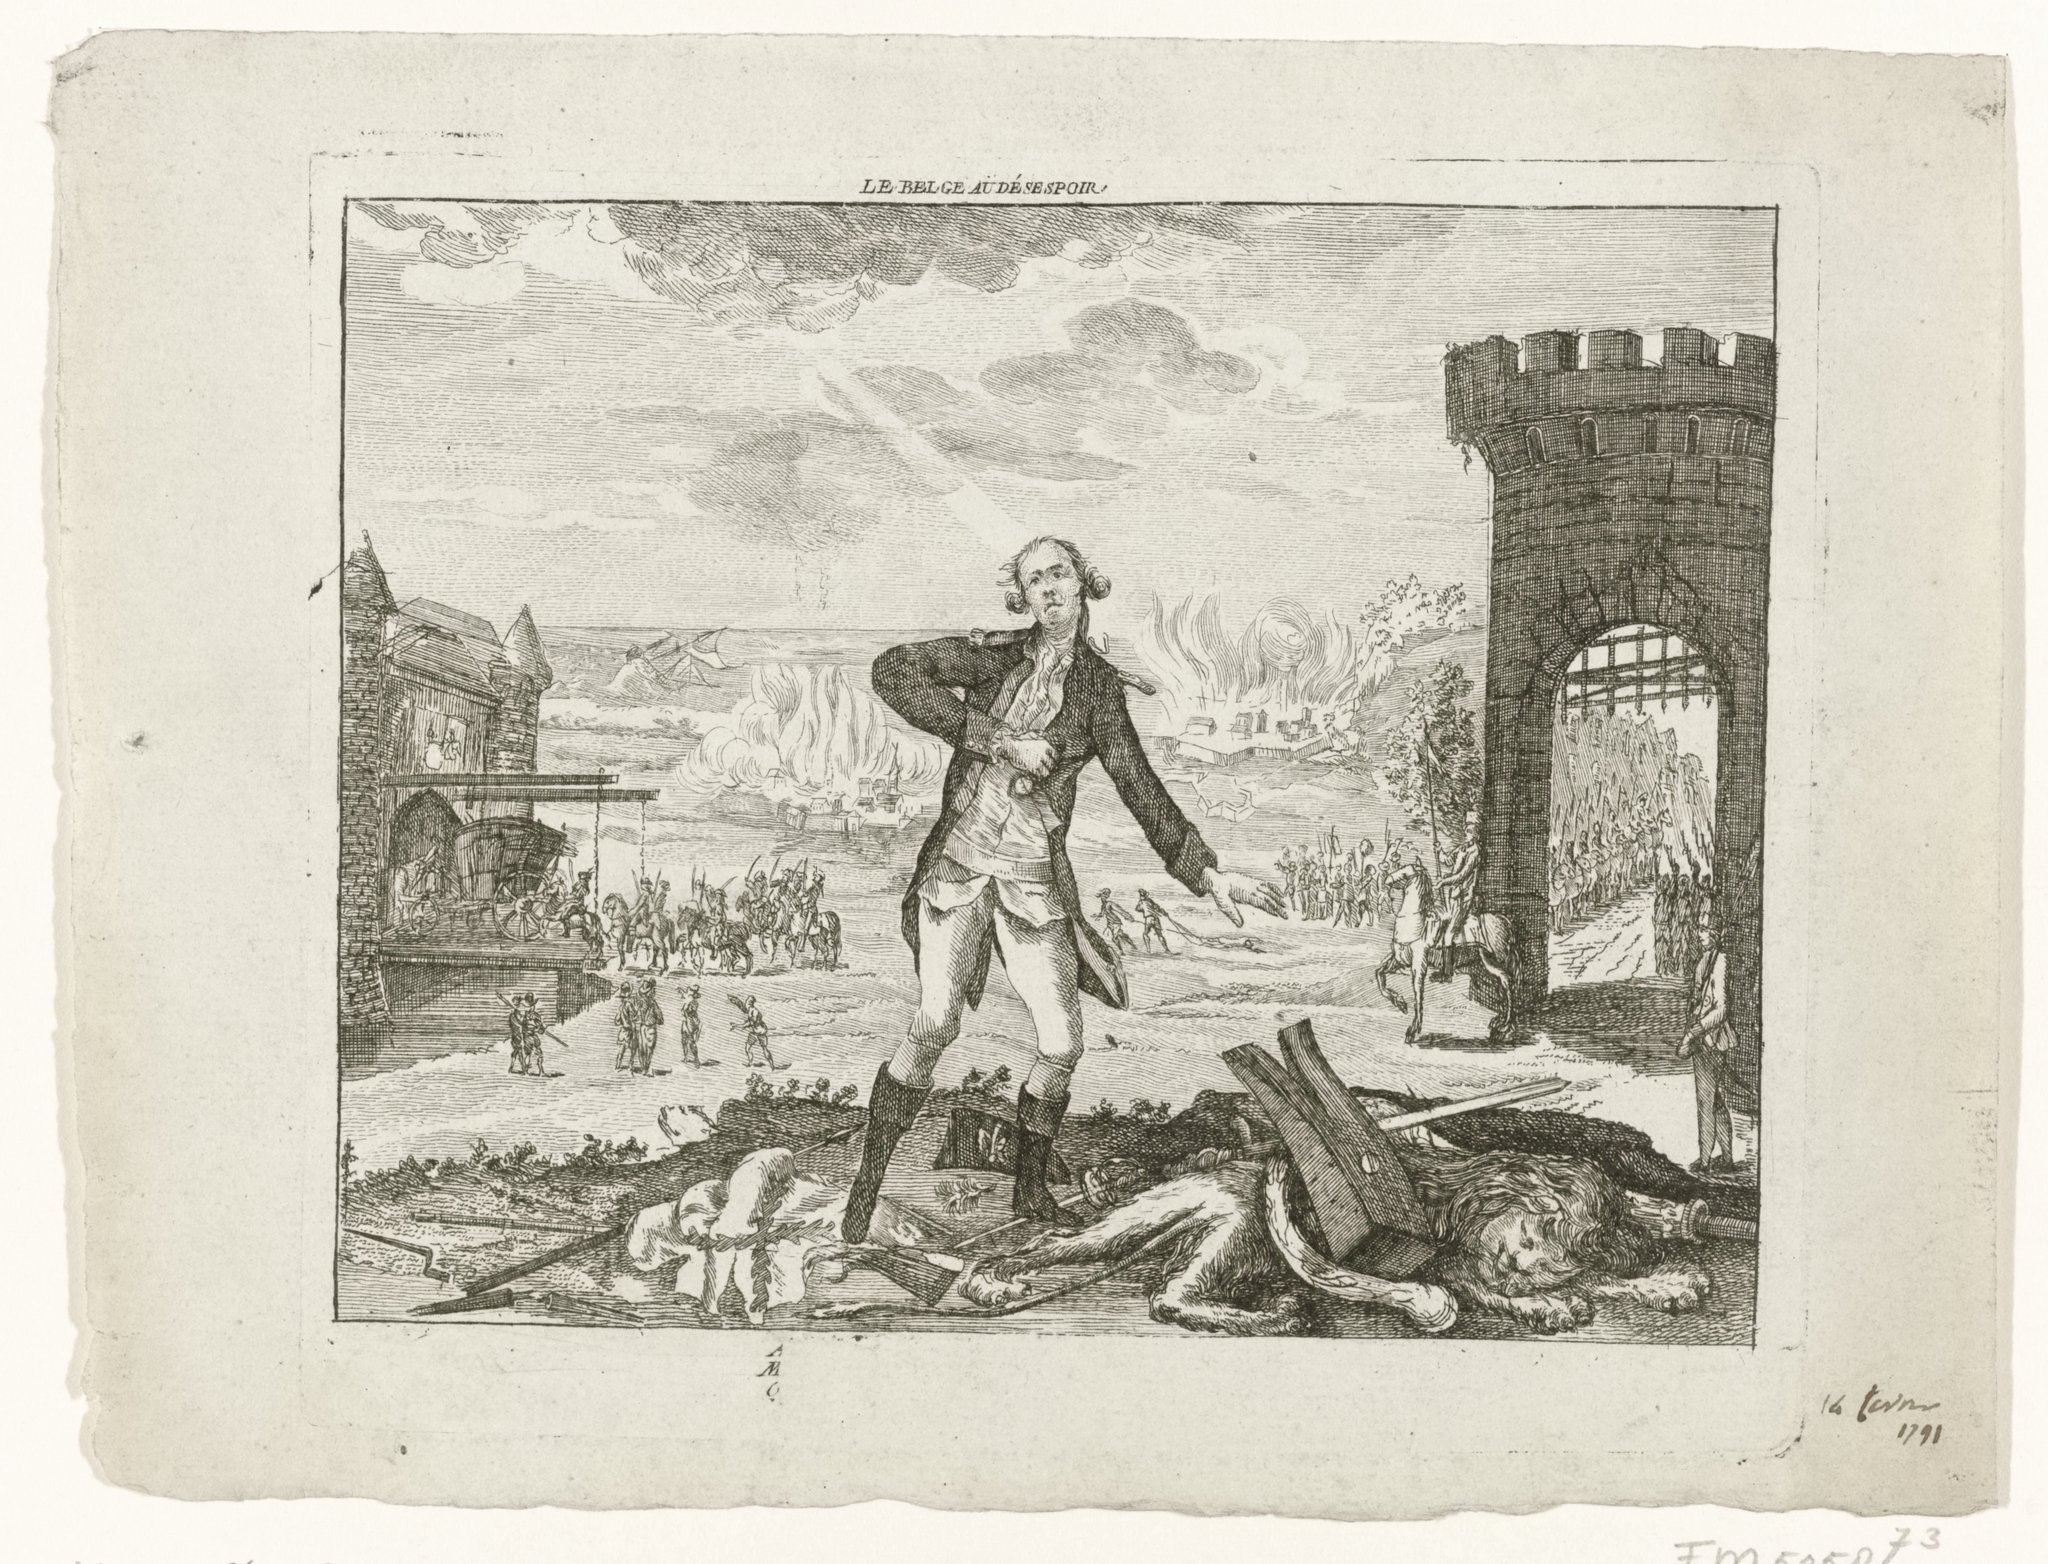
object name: print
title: Le Belge au Désespoir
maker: Anonymous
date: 1787-1791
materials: paper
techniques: engraving, etching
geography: southern netherlands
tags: march into the conquered place, brabant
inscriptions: collector's mark: Lugt 2228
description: Voor een landschap geteisterd door oorlog staat een wanhopige man die de Brabantse omwenteling personifieert. Voor hem ligt op de grond de gedode Brabantse leeuw, wapentuig en steek met kokarde. Met sporen van een onderschrift van drie regels. Hierbij de datum 14 februari 1791 met de hand geschreven. Onderdeel van een grote groep van prenten betrekking hebbend op de gebeurtenissen van de Brabantse Omwenteling en de periode 1787-1790.